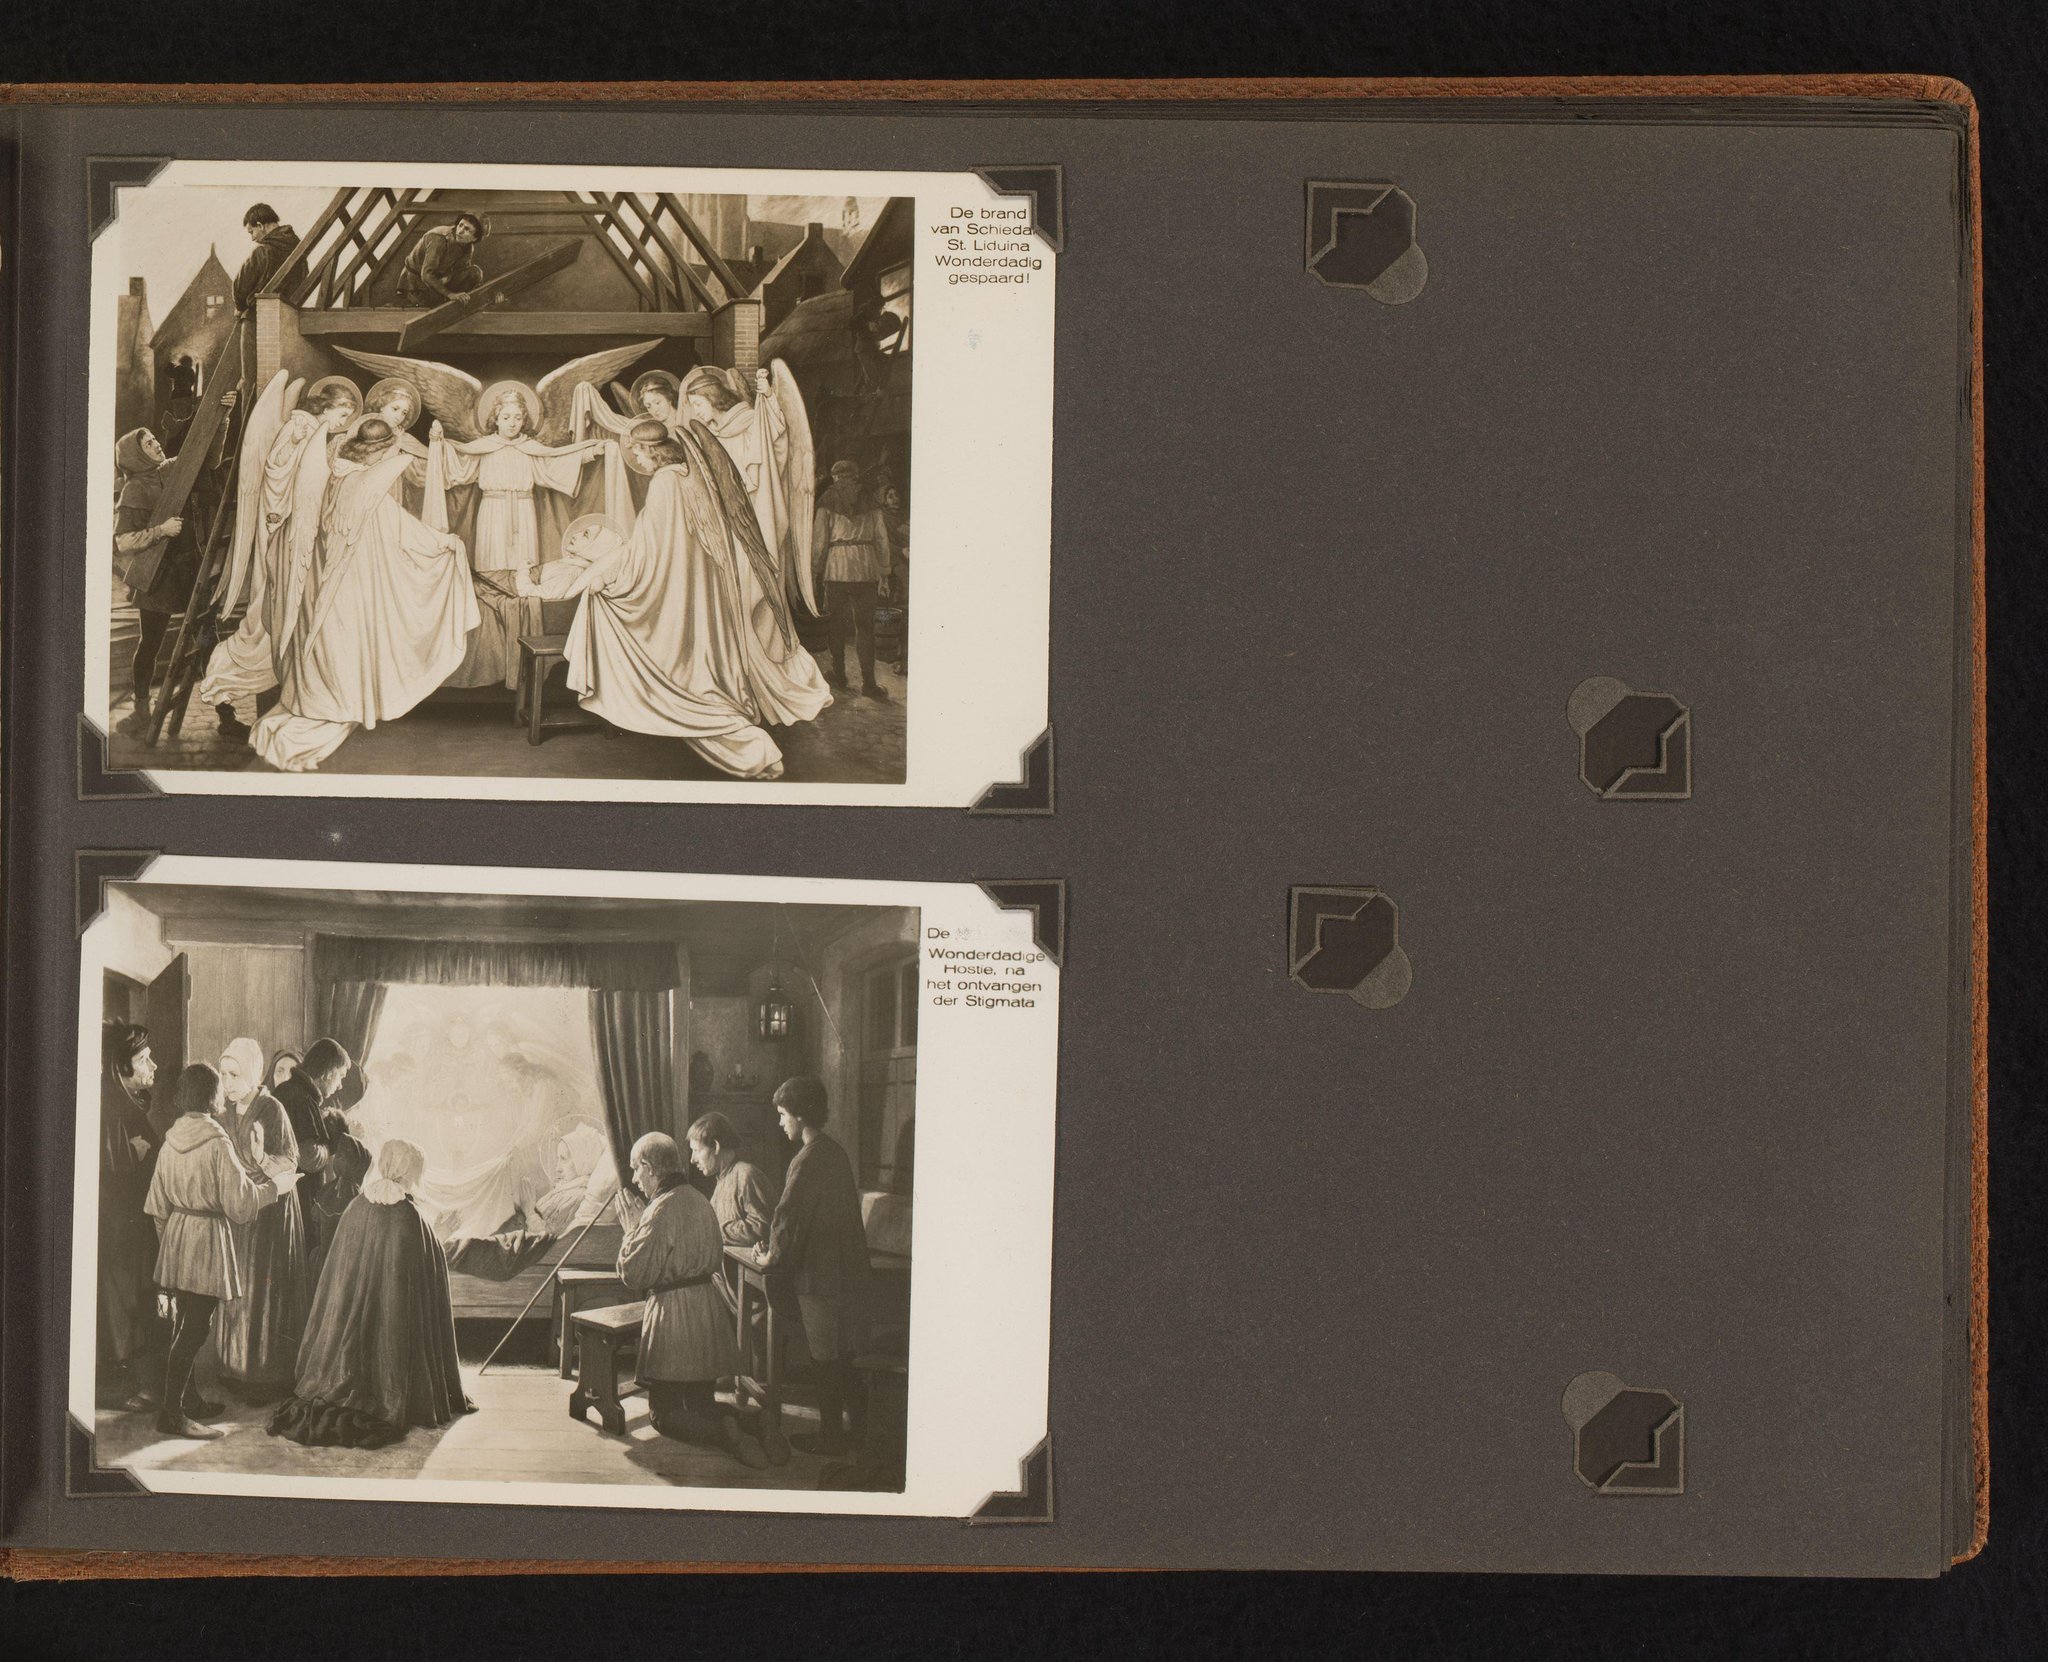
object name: photograph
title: Prentbriefkaarten van schilderijen van de heilige Liduina van Schiedam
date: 1925-1933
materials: paper, photographic support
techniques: gelatin silver print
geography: schiedam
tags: the virgin lidwyna (lydwine) of schiedam; possible attributes: crucifix, branch of roses in hand, roses in hair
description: Albumblad met twee prentbriefkaarten naar schilderijen van de heilige Liduina van Schiedam in de St. Liduinabasiliek. Onderdeel van het Esperanto album uit ca. 1933-1936.